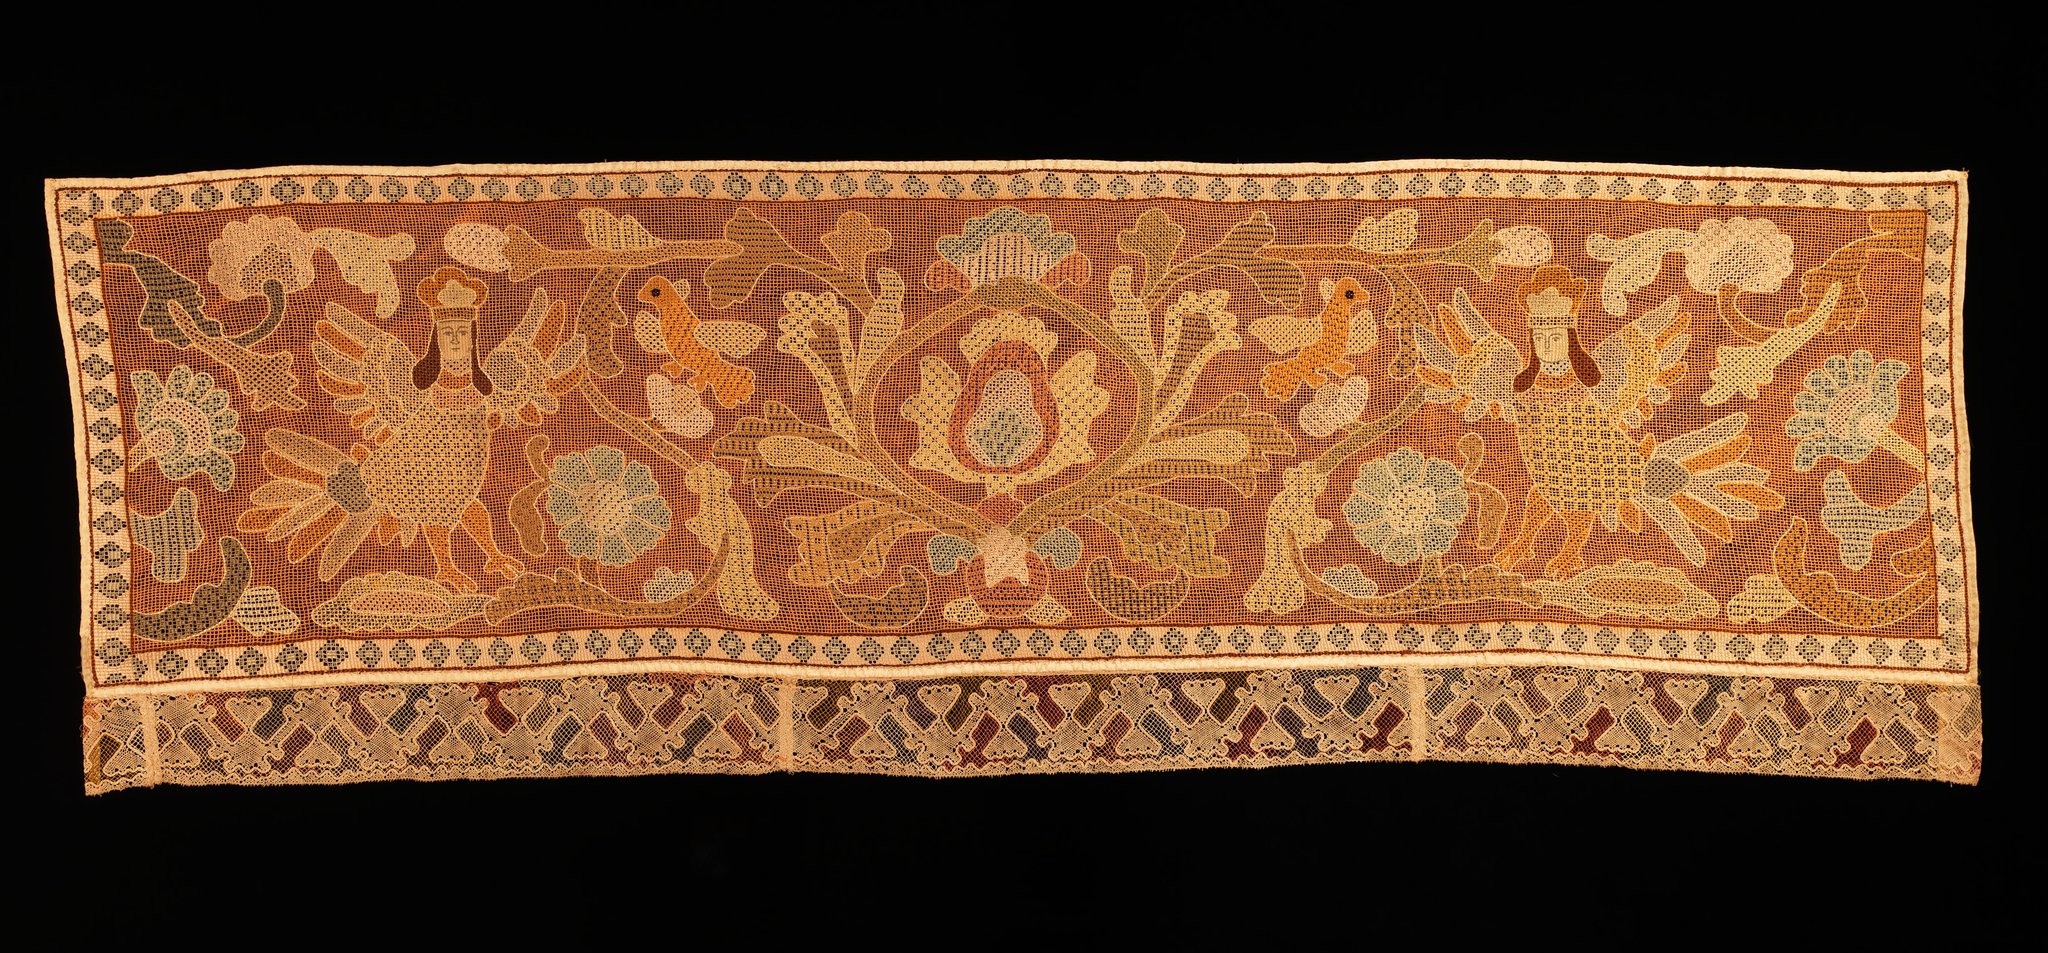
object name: border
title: Bed curtain border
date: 1801-1833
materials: linen, silk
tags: birds